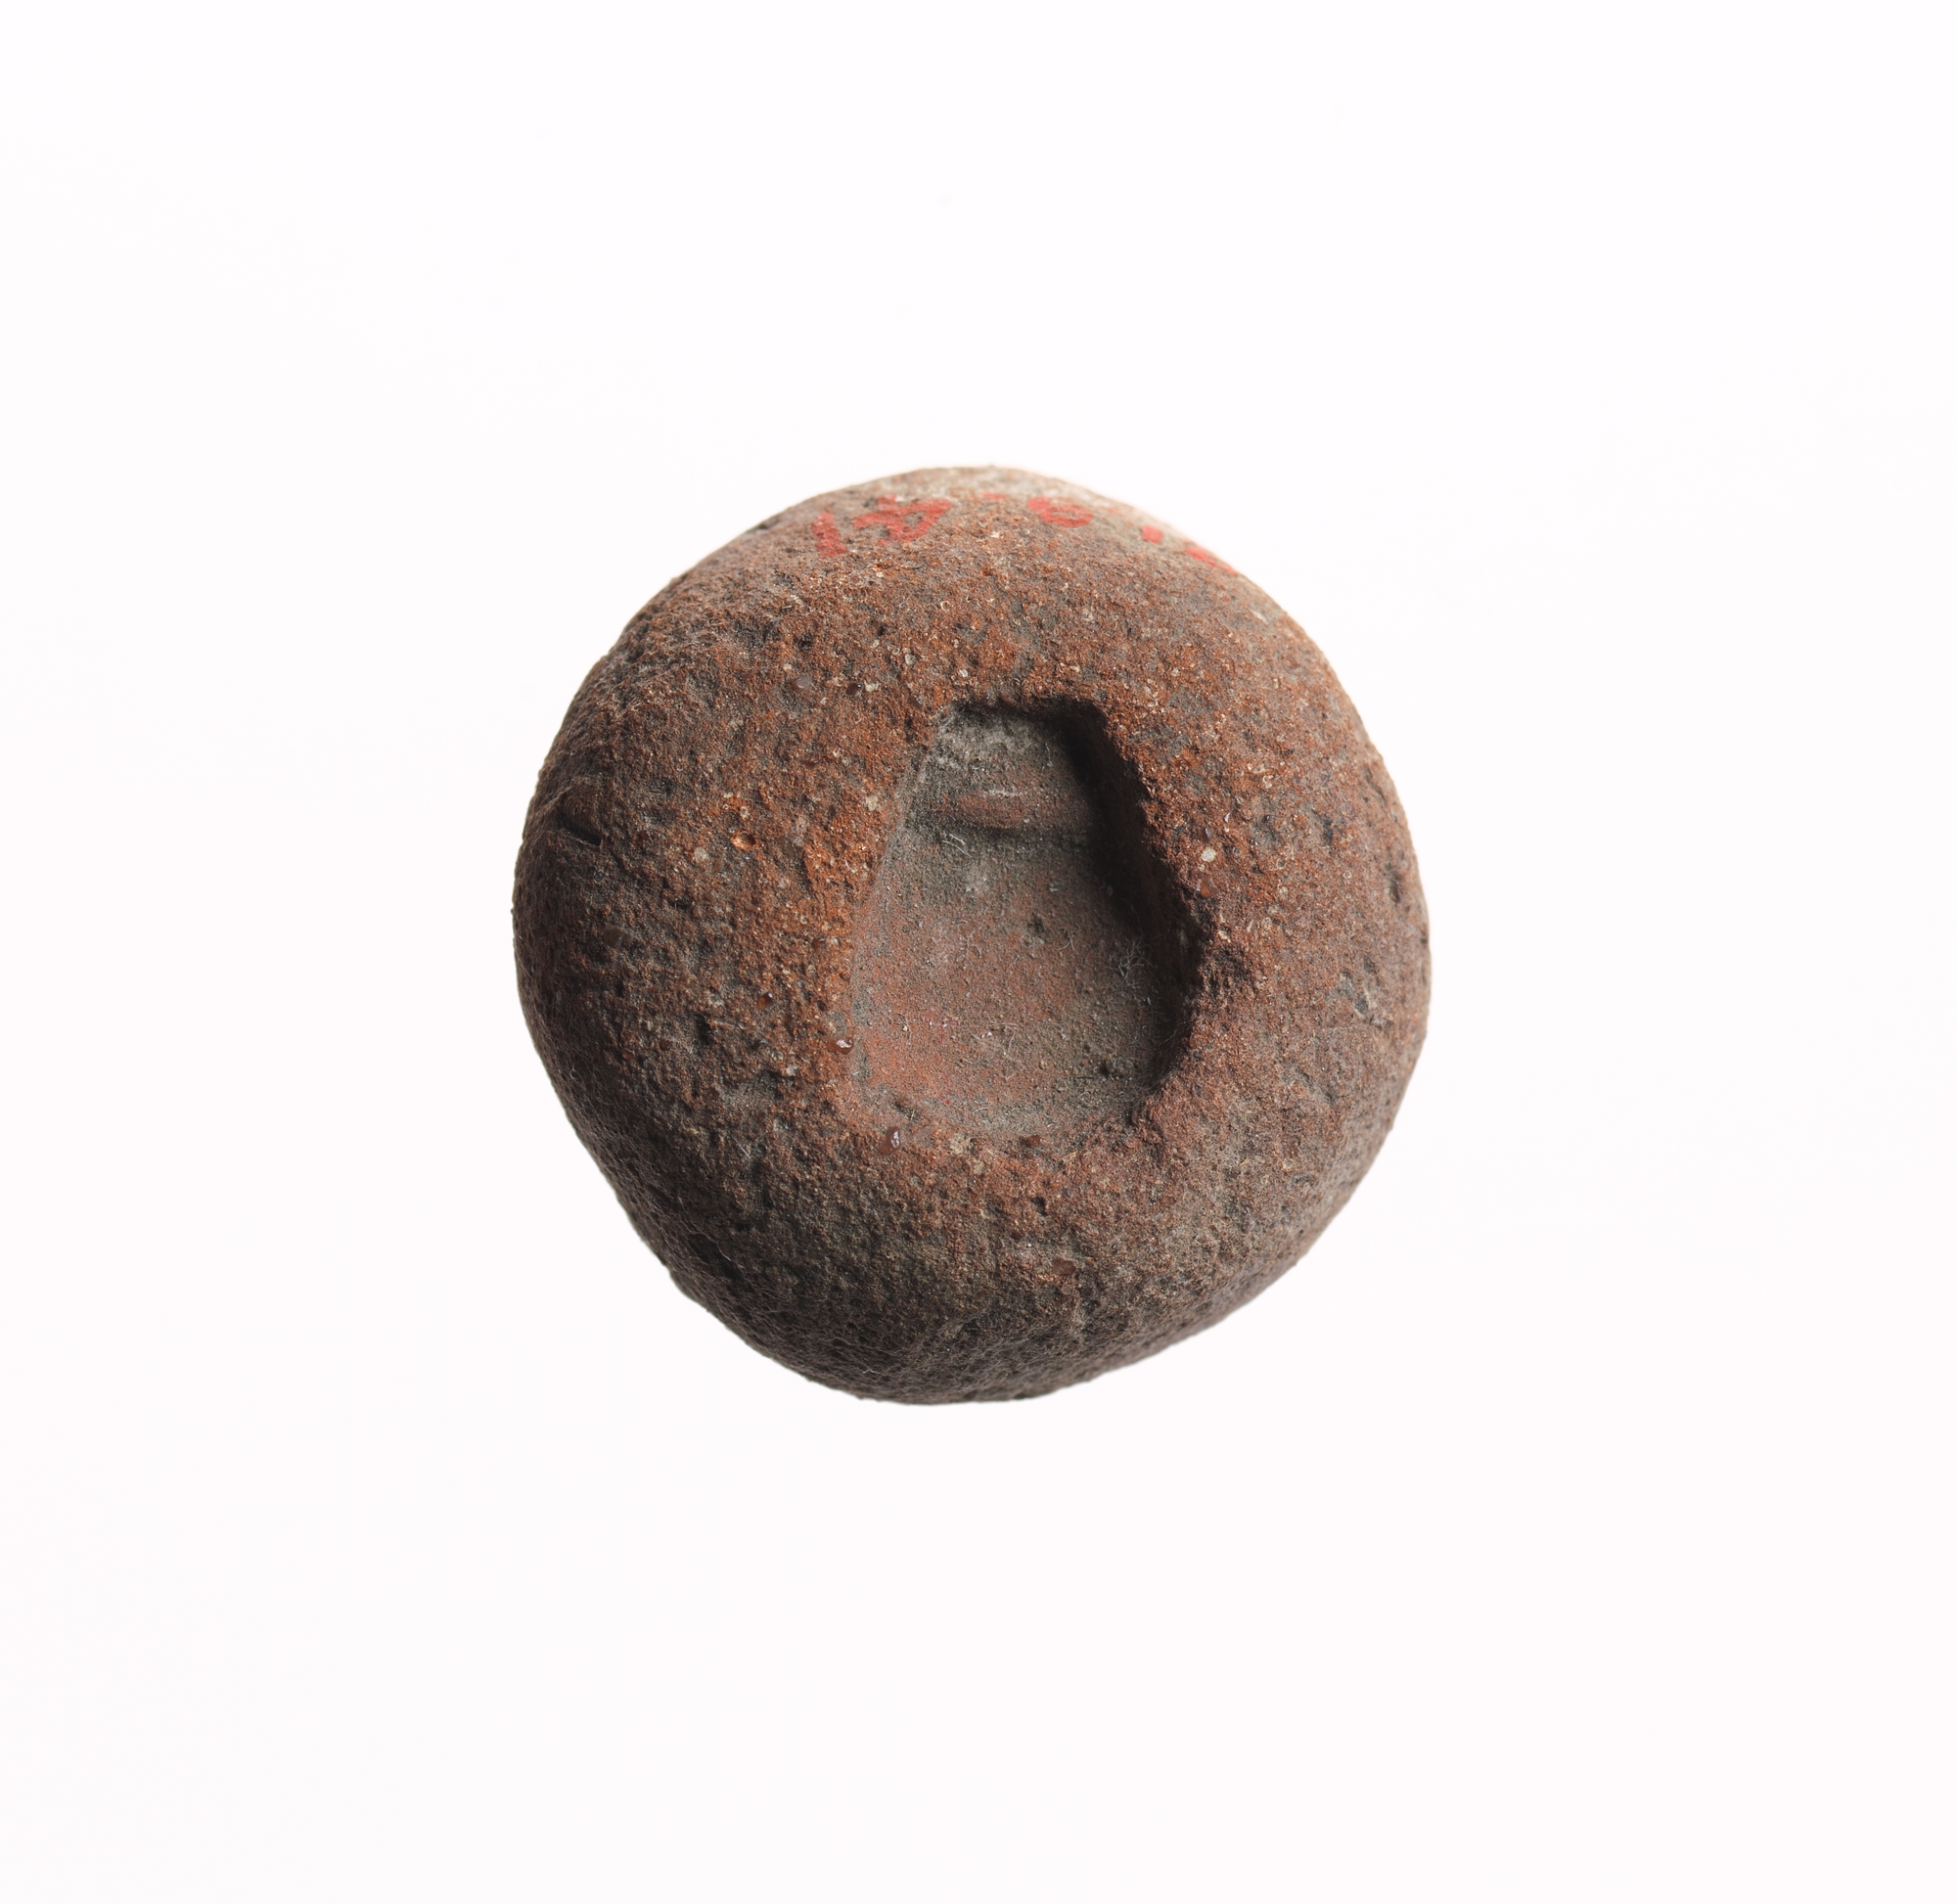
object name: mold, poppy petal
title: Mold for a Poppy Petal Pendant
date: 1353-1336 BCE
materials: pottery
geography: egypt